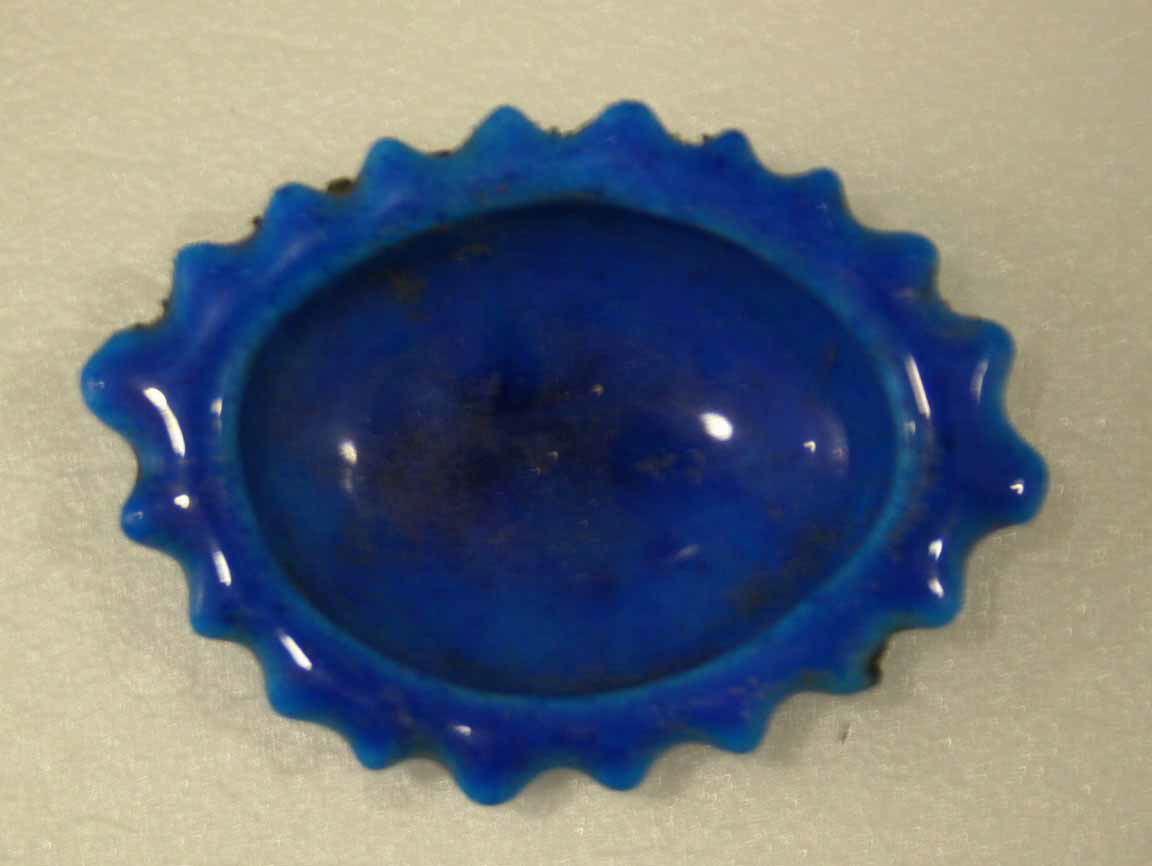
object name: salt cellar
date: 1867-1900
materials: stonepaste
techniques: glazing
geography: iran